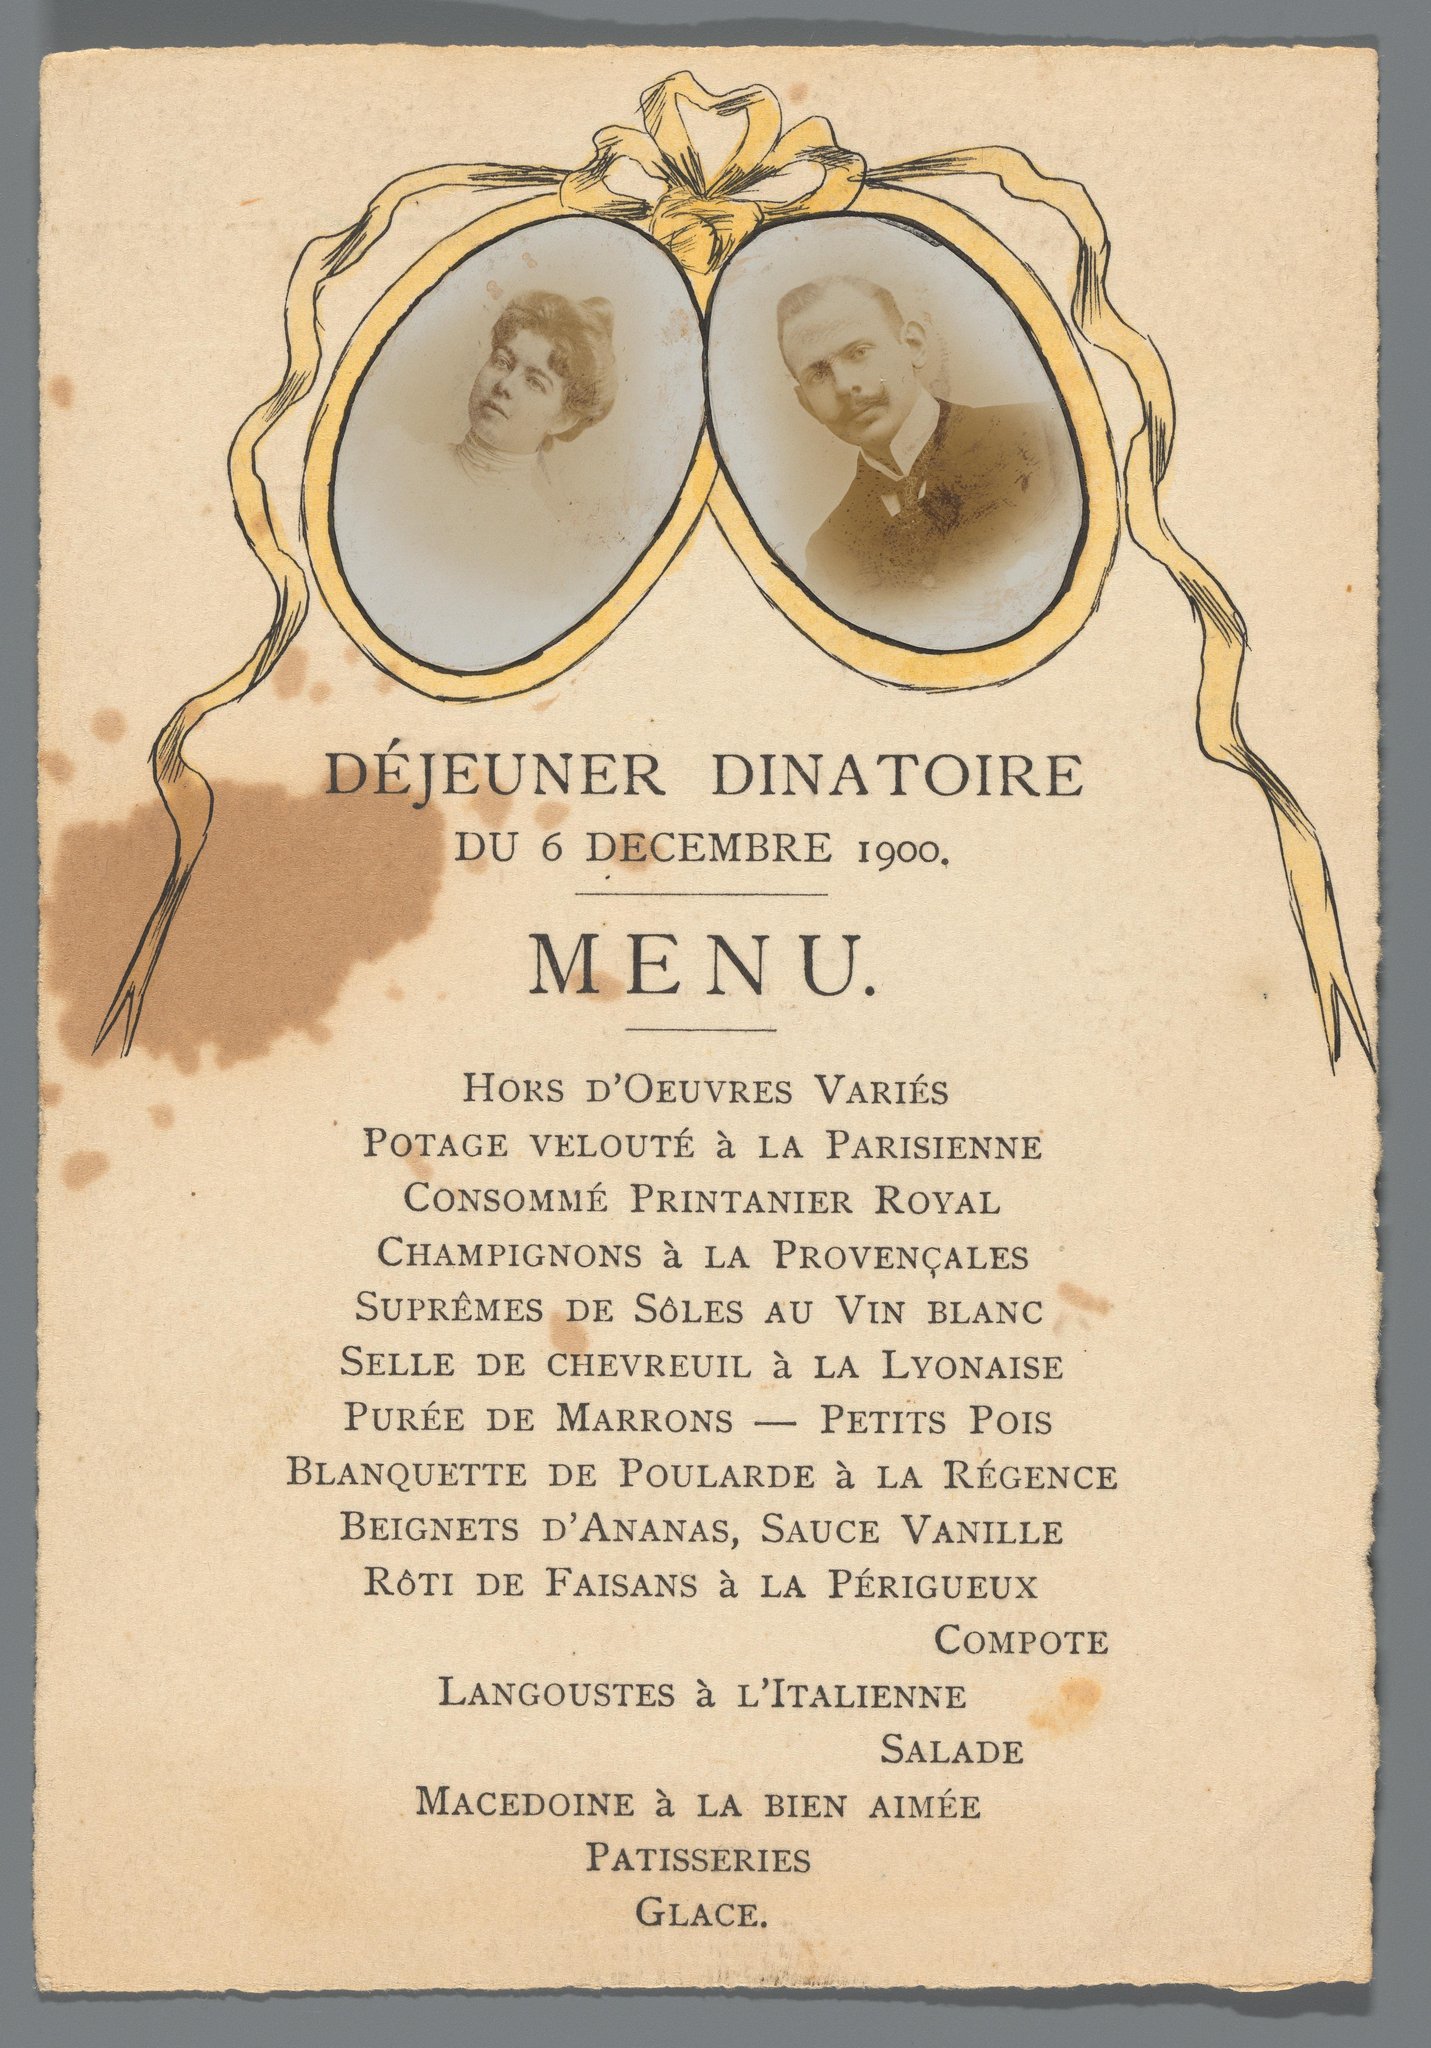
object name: photograph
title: Menukaart met 2 ovale fotoportretten van A.C.M. Geertsema en Karel Frederik van den Berg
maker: Anonymous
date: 1890-1900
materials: cardboard, photographic support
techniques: albumen print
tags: batavia, karel frederik van den berg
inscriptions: inscription: ‘gekregen 6 oktober 1981 / van A. baron Wagemhoff’